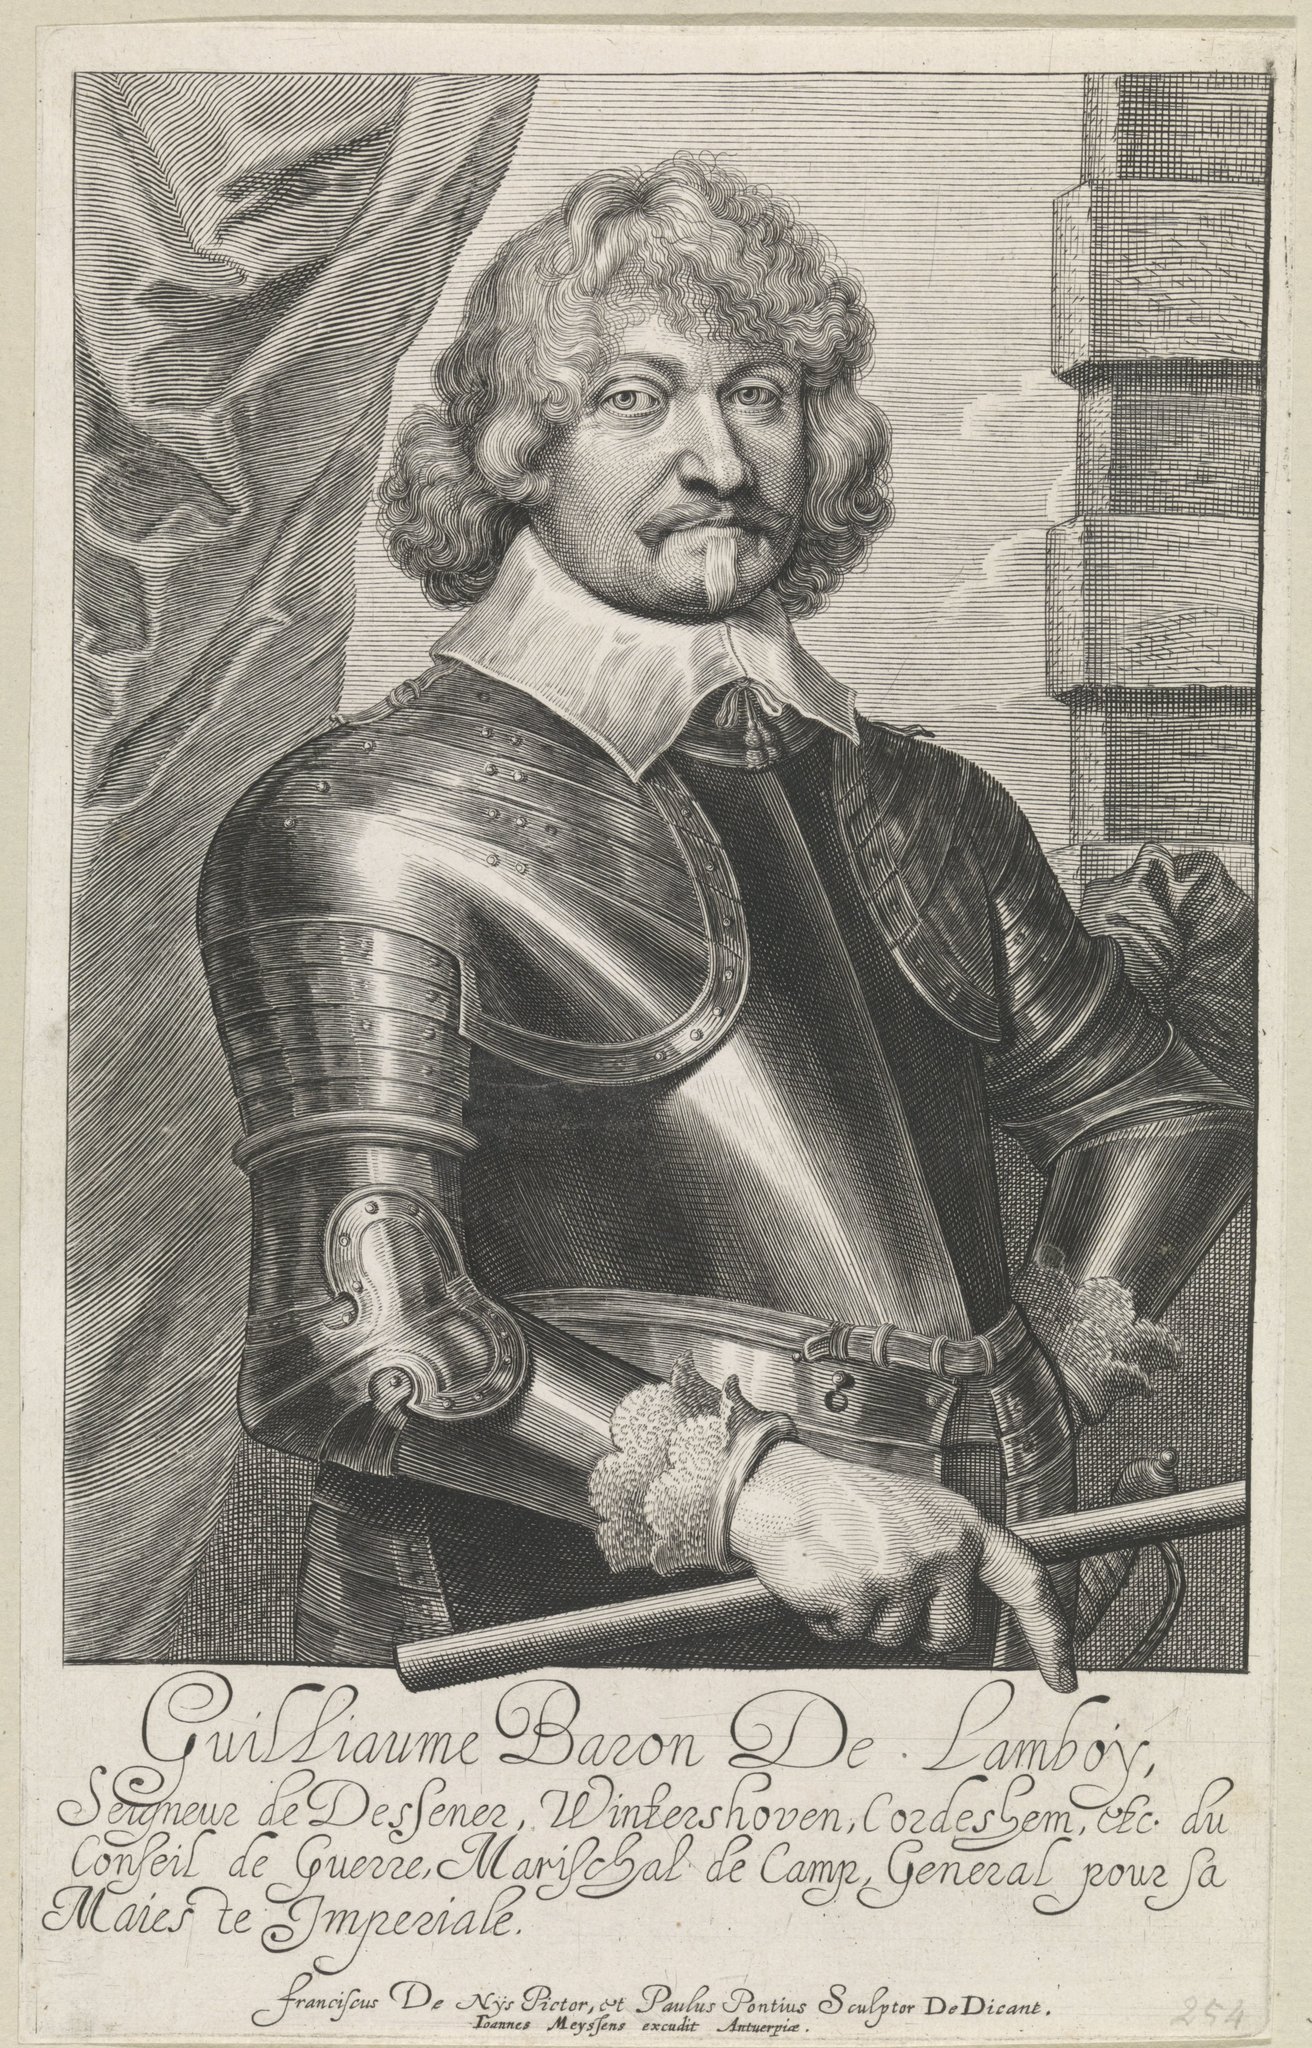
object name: print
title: Portret van Guillaume, baron van Lamboy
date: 1616-1657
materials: paper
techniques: engraving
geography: antwerp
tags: armour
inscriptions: collector's mark: Lugt 240